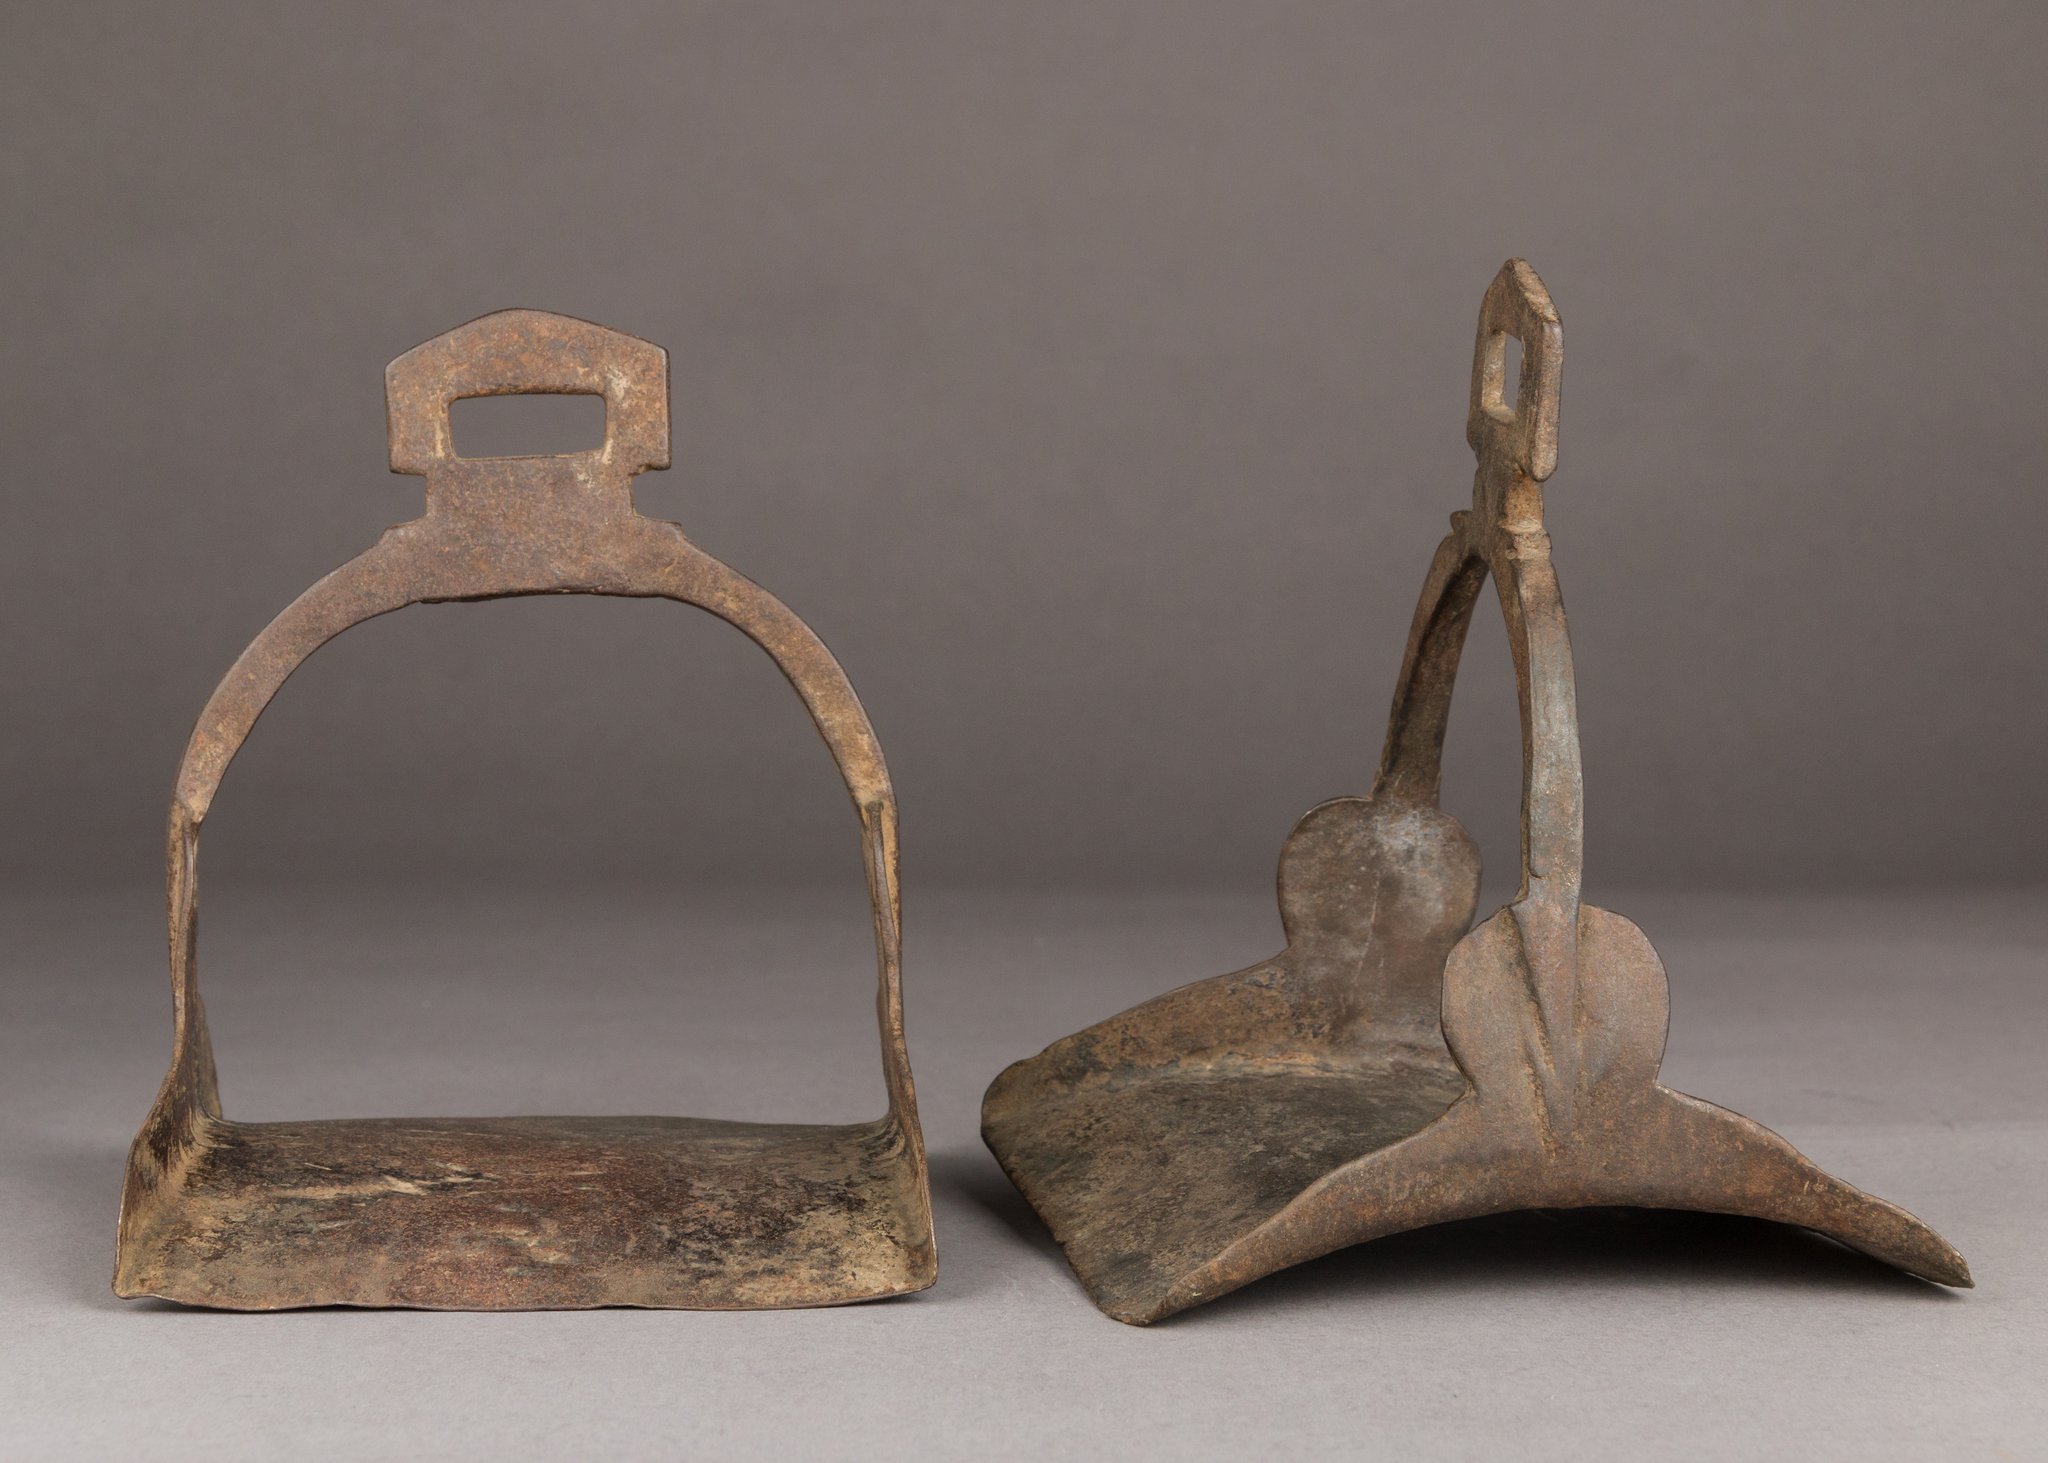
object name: stirrup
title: Two Stirrups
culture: armenian or syrian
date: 1801-1900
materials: iron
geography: armenia